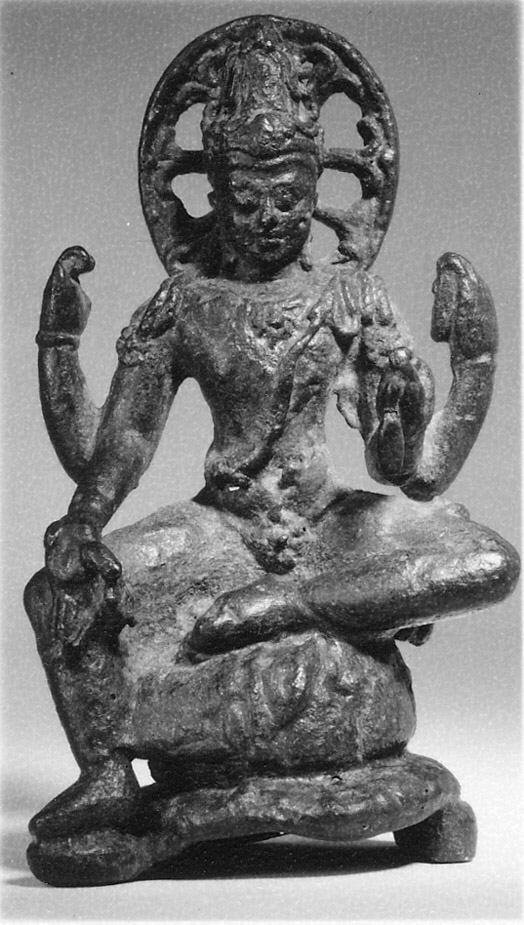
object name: figure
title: Seated Avalokiteshvara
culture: indonesian, sumatran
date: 901-1100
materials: bronze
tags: buddhism,avalokiteshvara,bodhisattvas